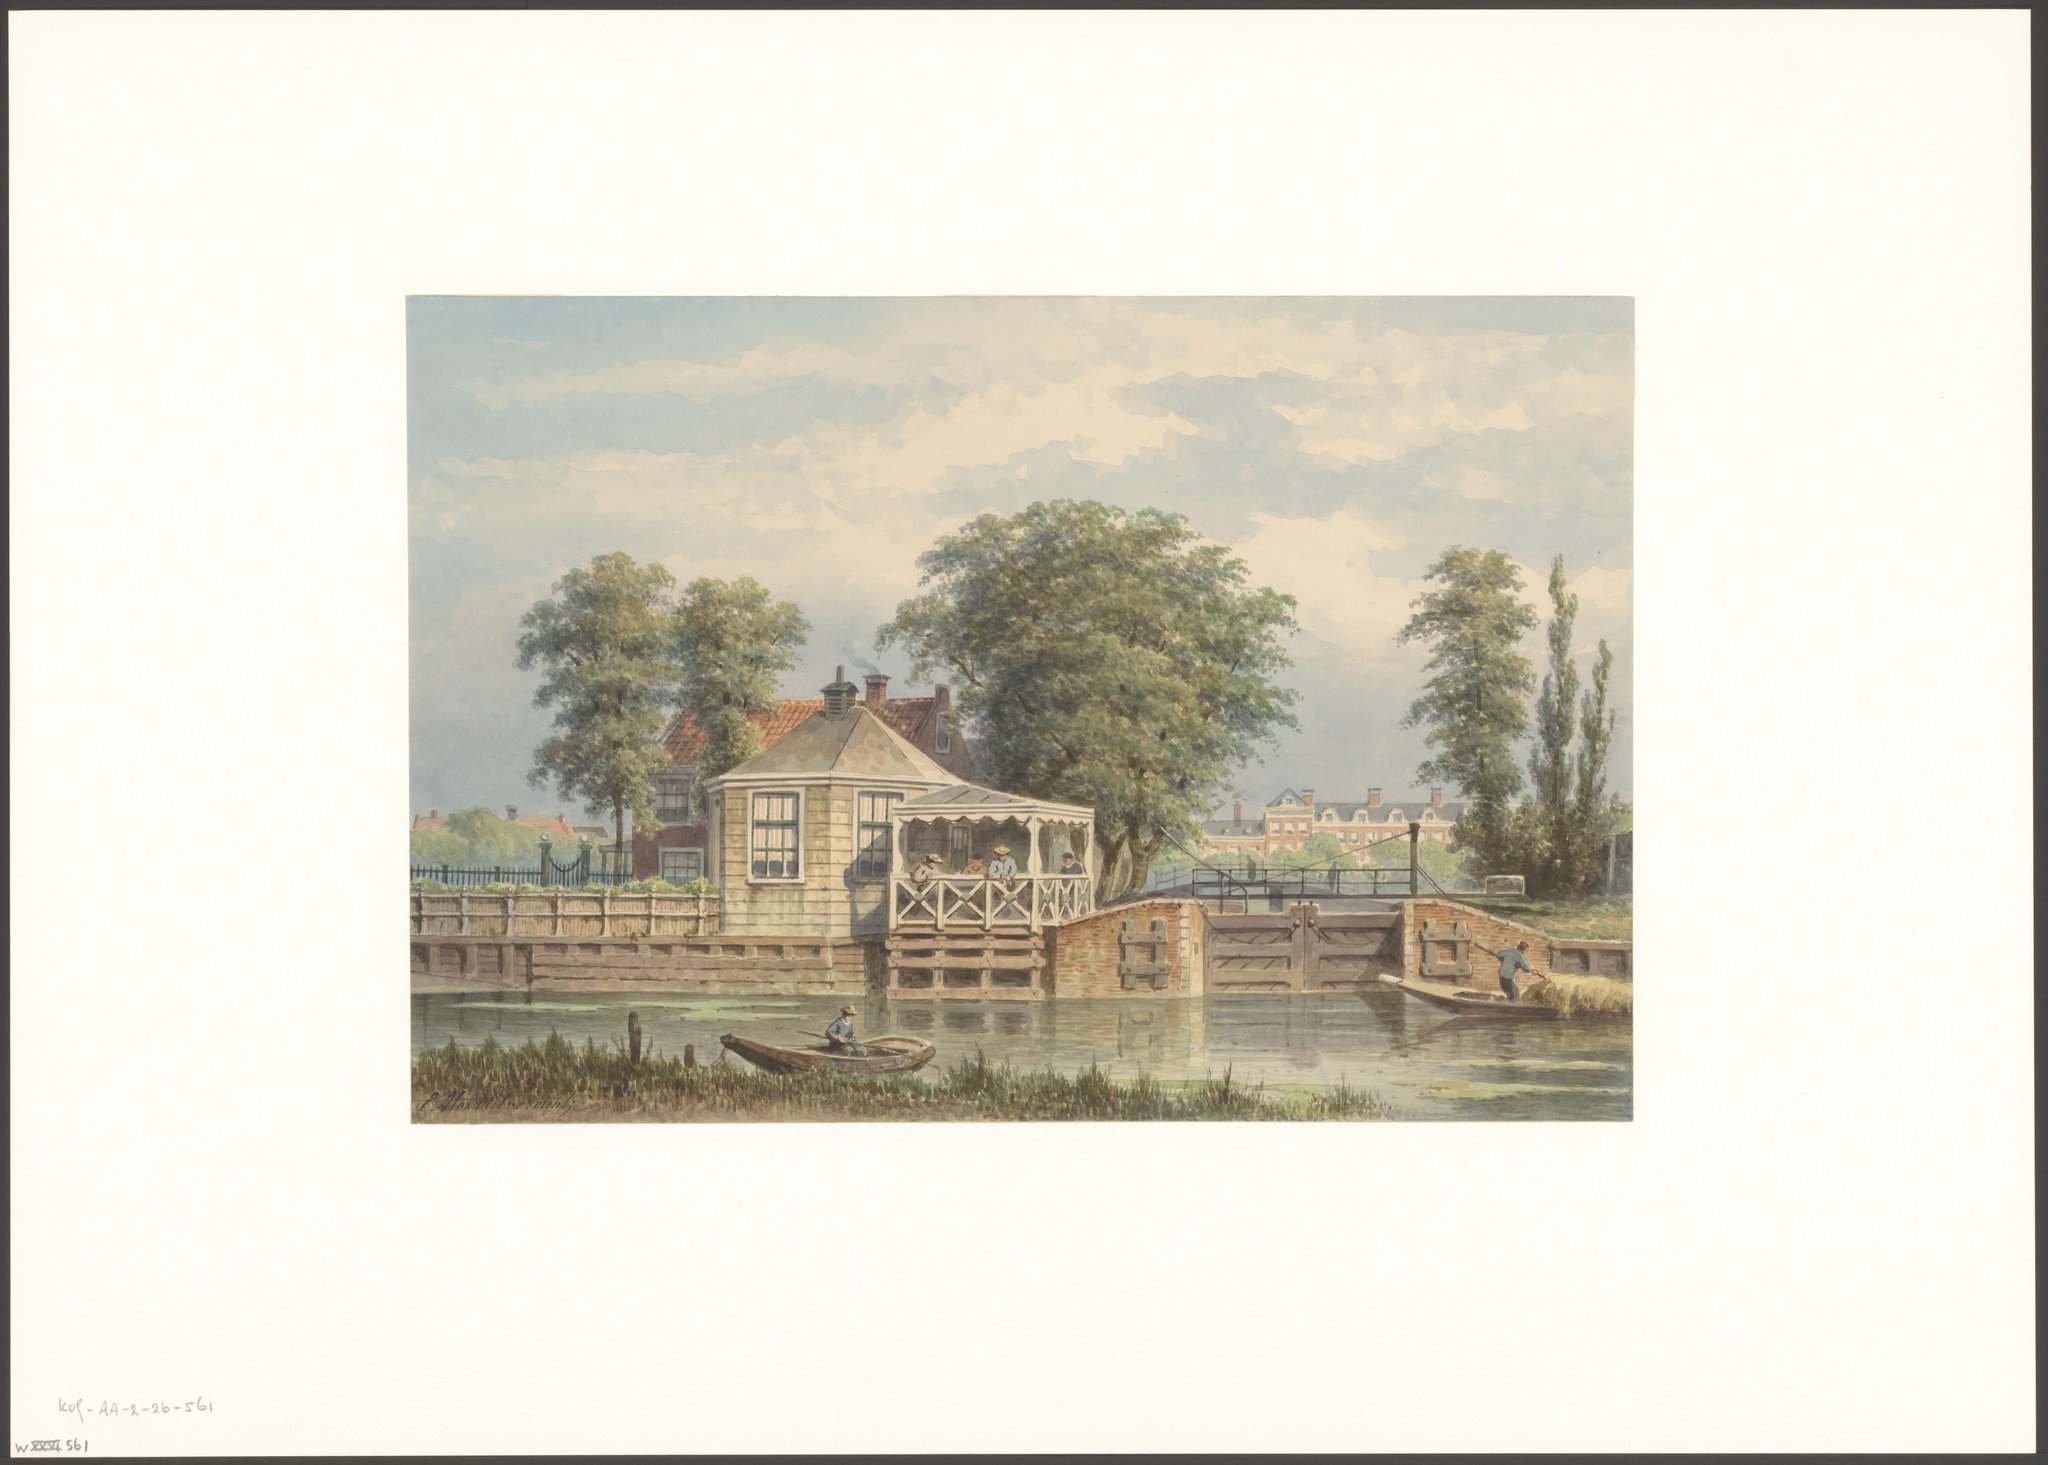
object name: drawing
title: Gezicht op het Polderhuis aan de Stadhouderskade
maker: eduard alexander hilverdink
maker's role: draughtsman, painter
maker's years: 1846-1891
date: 1856-1891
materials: paper, pencil, watercolor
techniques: brush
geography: amsterdam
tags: city-view in general; 'veduta', canal, inn, coffee-house, public house, etc.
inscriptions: signature: ‘E Alex Hilverdink’, collector's mark: Lugt 800a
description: Tekening binnen de Atlas Van Eck ingedeeld op wijknummer 26.